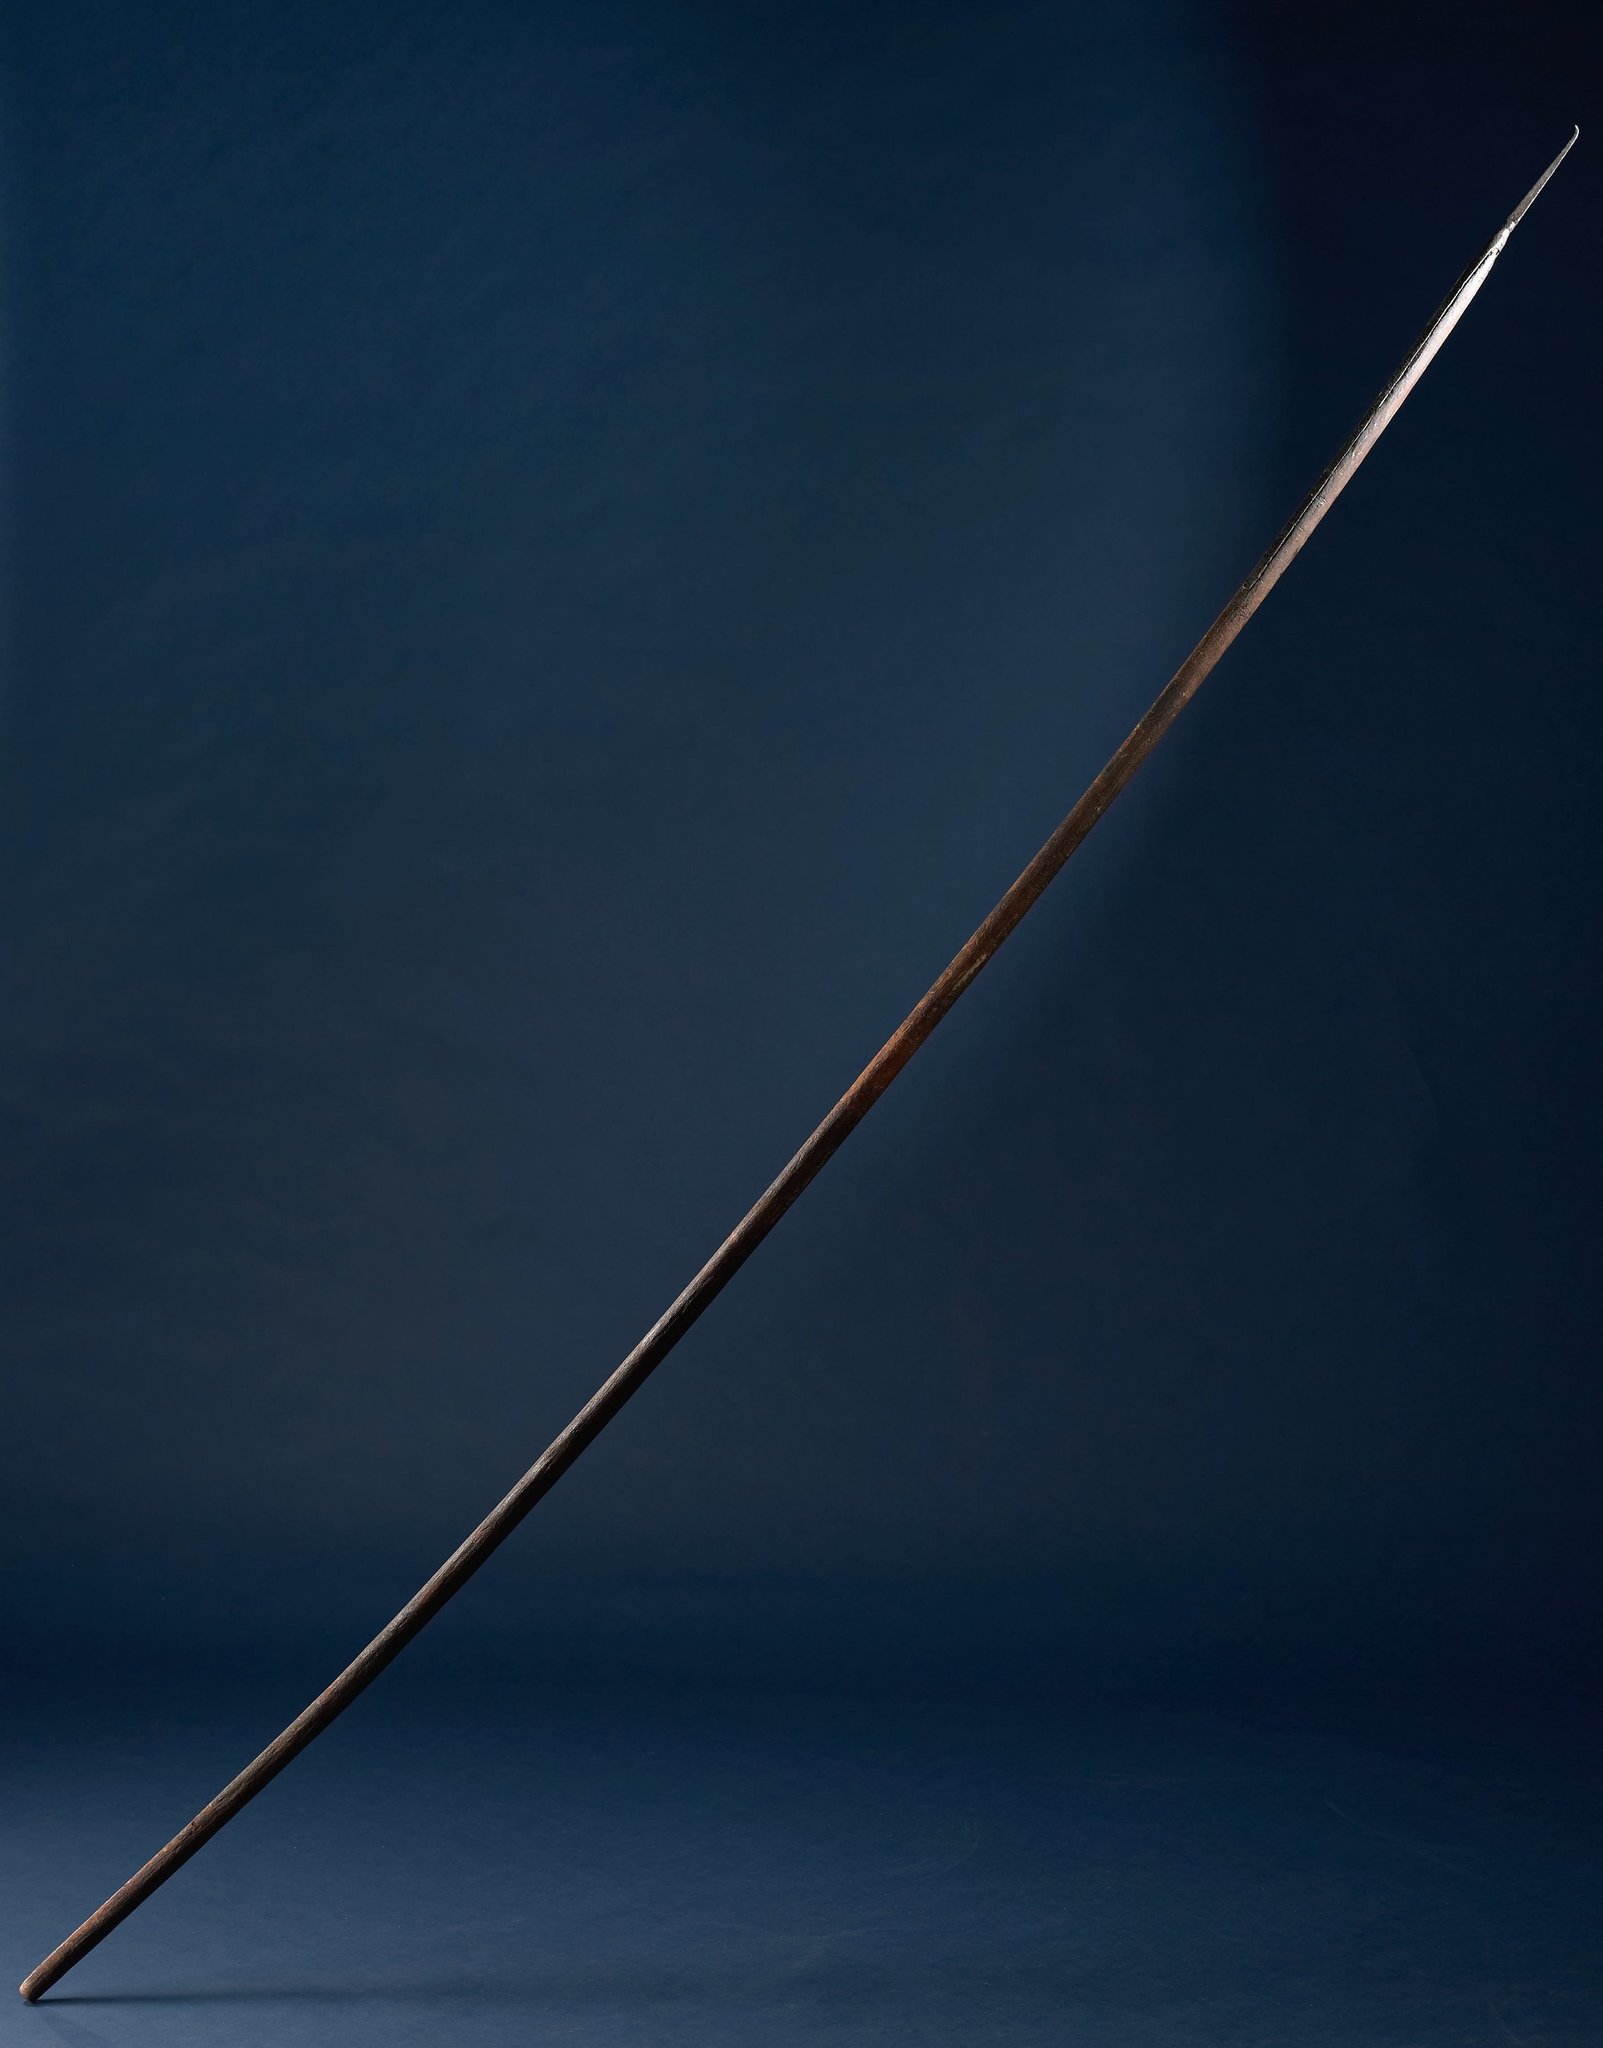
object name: pike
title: Piek van ijzer met veren vastgeklonken aan een houten steel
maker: Anonymous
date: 1590-1596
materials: iron, wood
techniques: cutting, forging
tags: willem barendsz., amsterdam, jacob van heemskerck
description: Weapons. Weapons were an essential part of any distant voyage. On Nova Zembla they were used to keep the polar bears at bay.